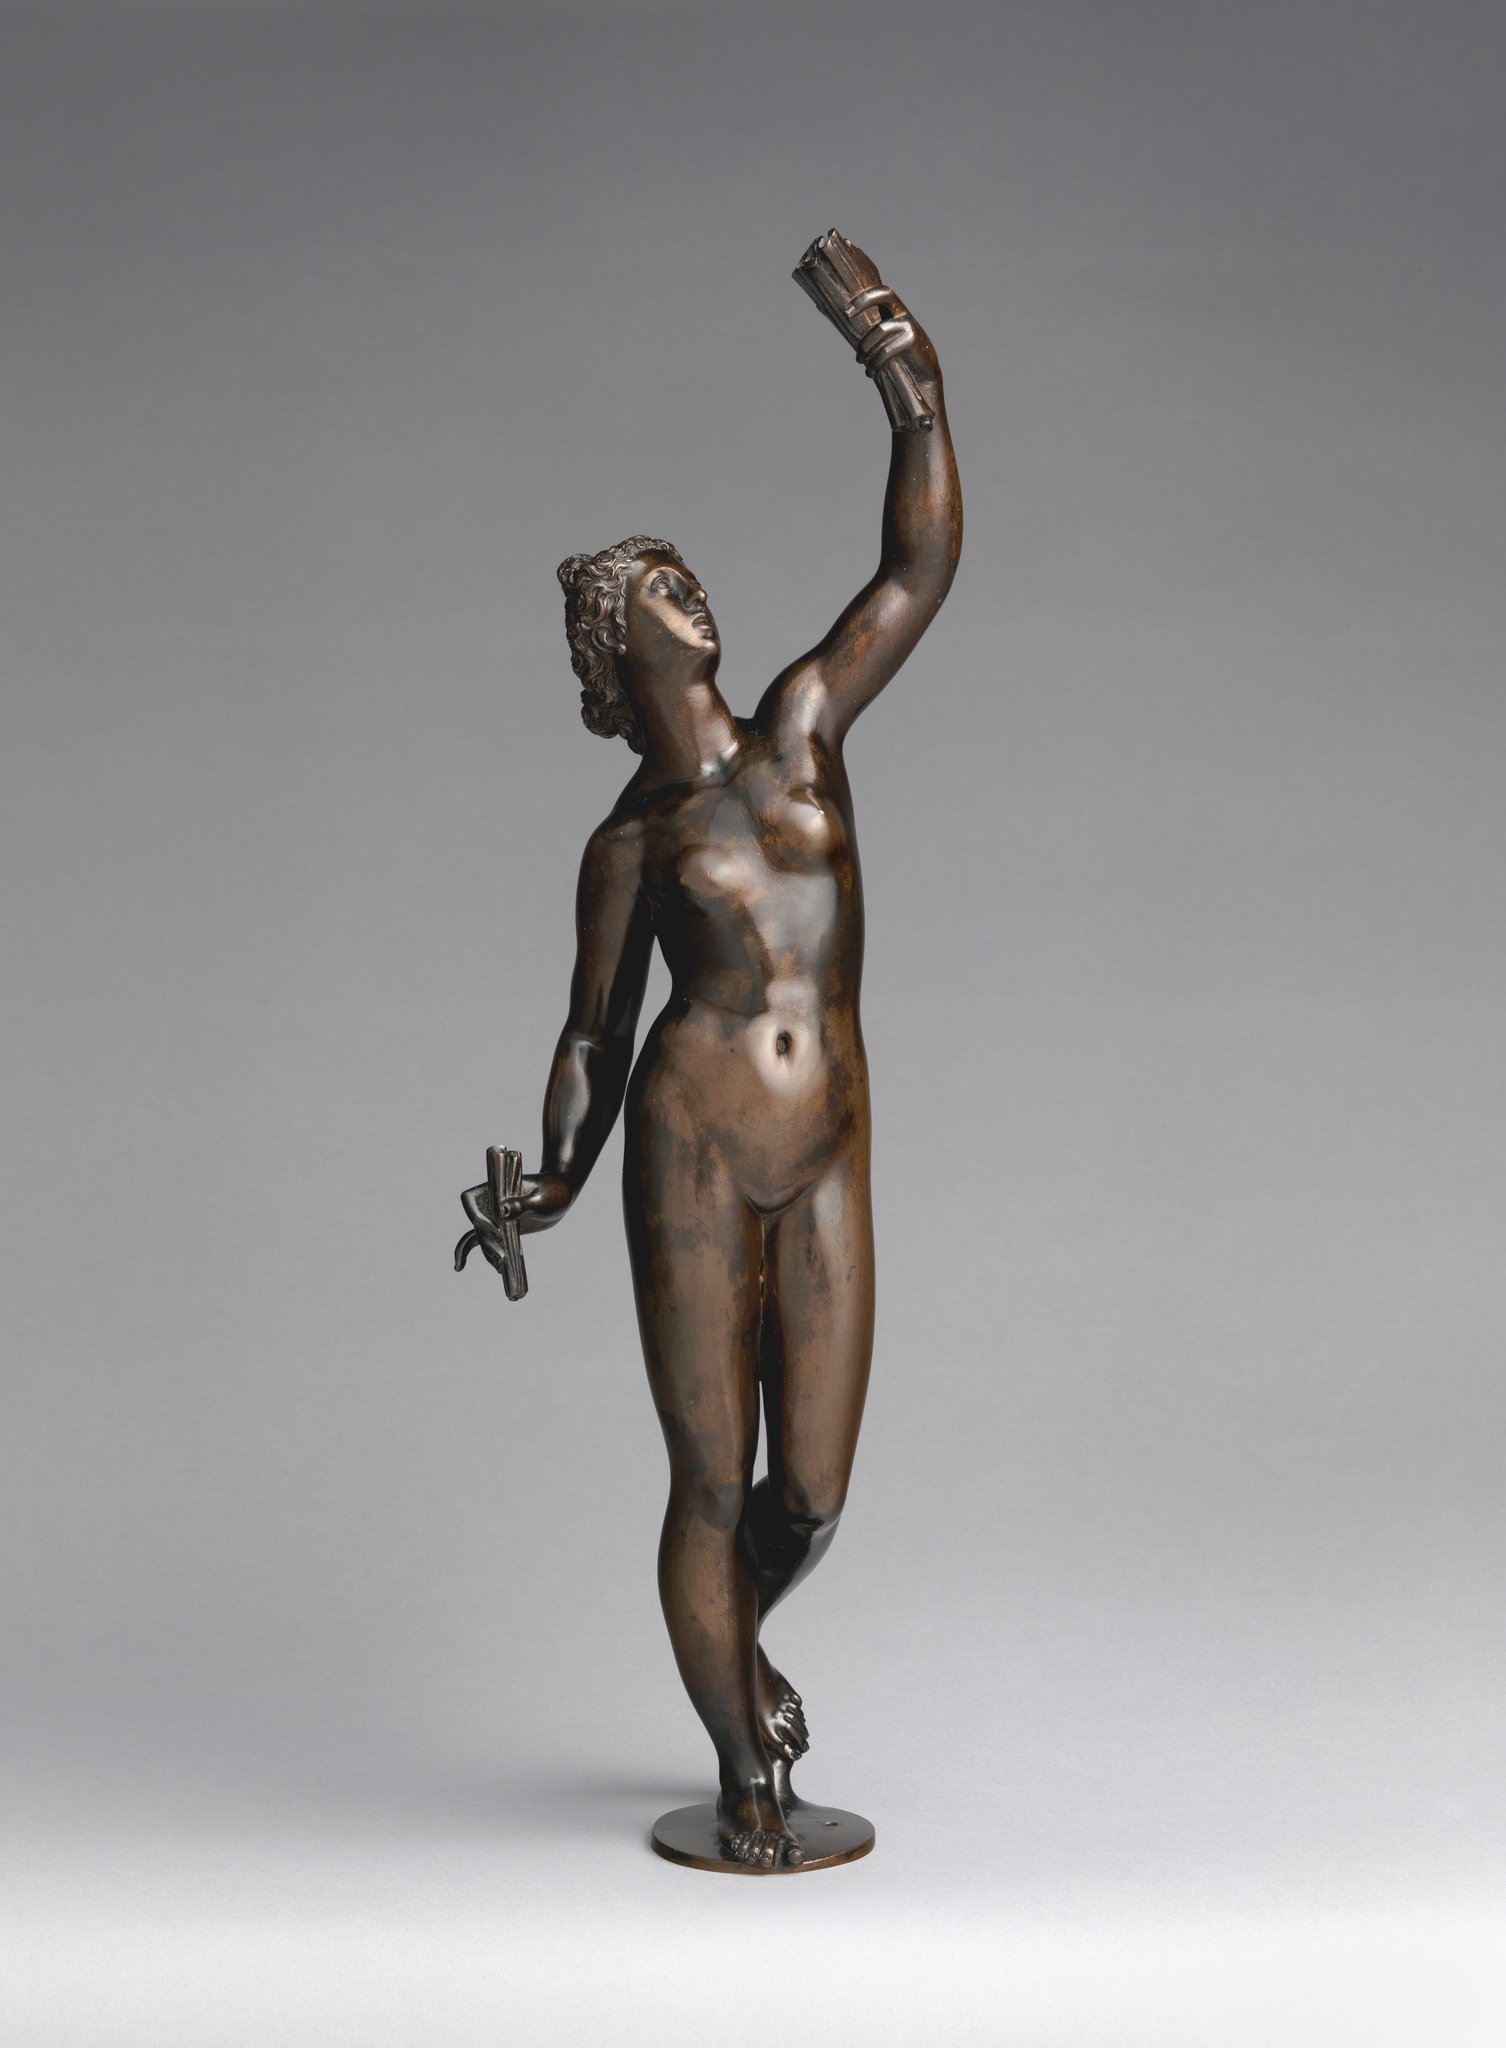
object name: statuette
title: Fortuna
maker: giambologna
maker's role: artist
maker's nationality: netherlandish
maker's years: 1529-1608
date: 1601-1633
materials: bronze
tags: female nudes